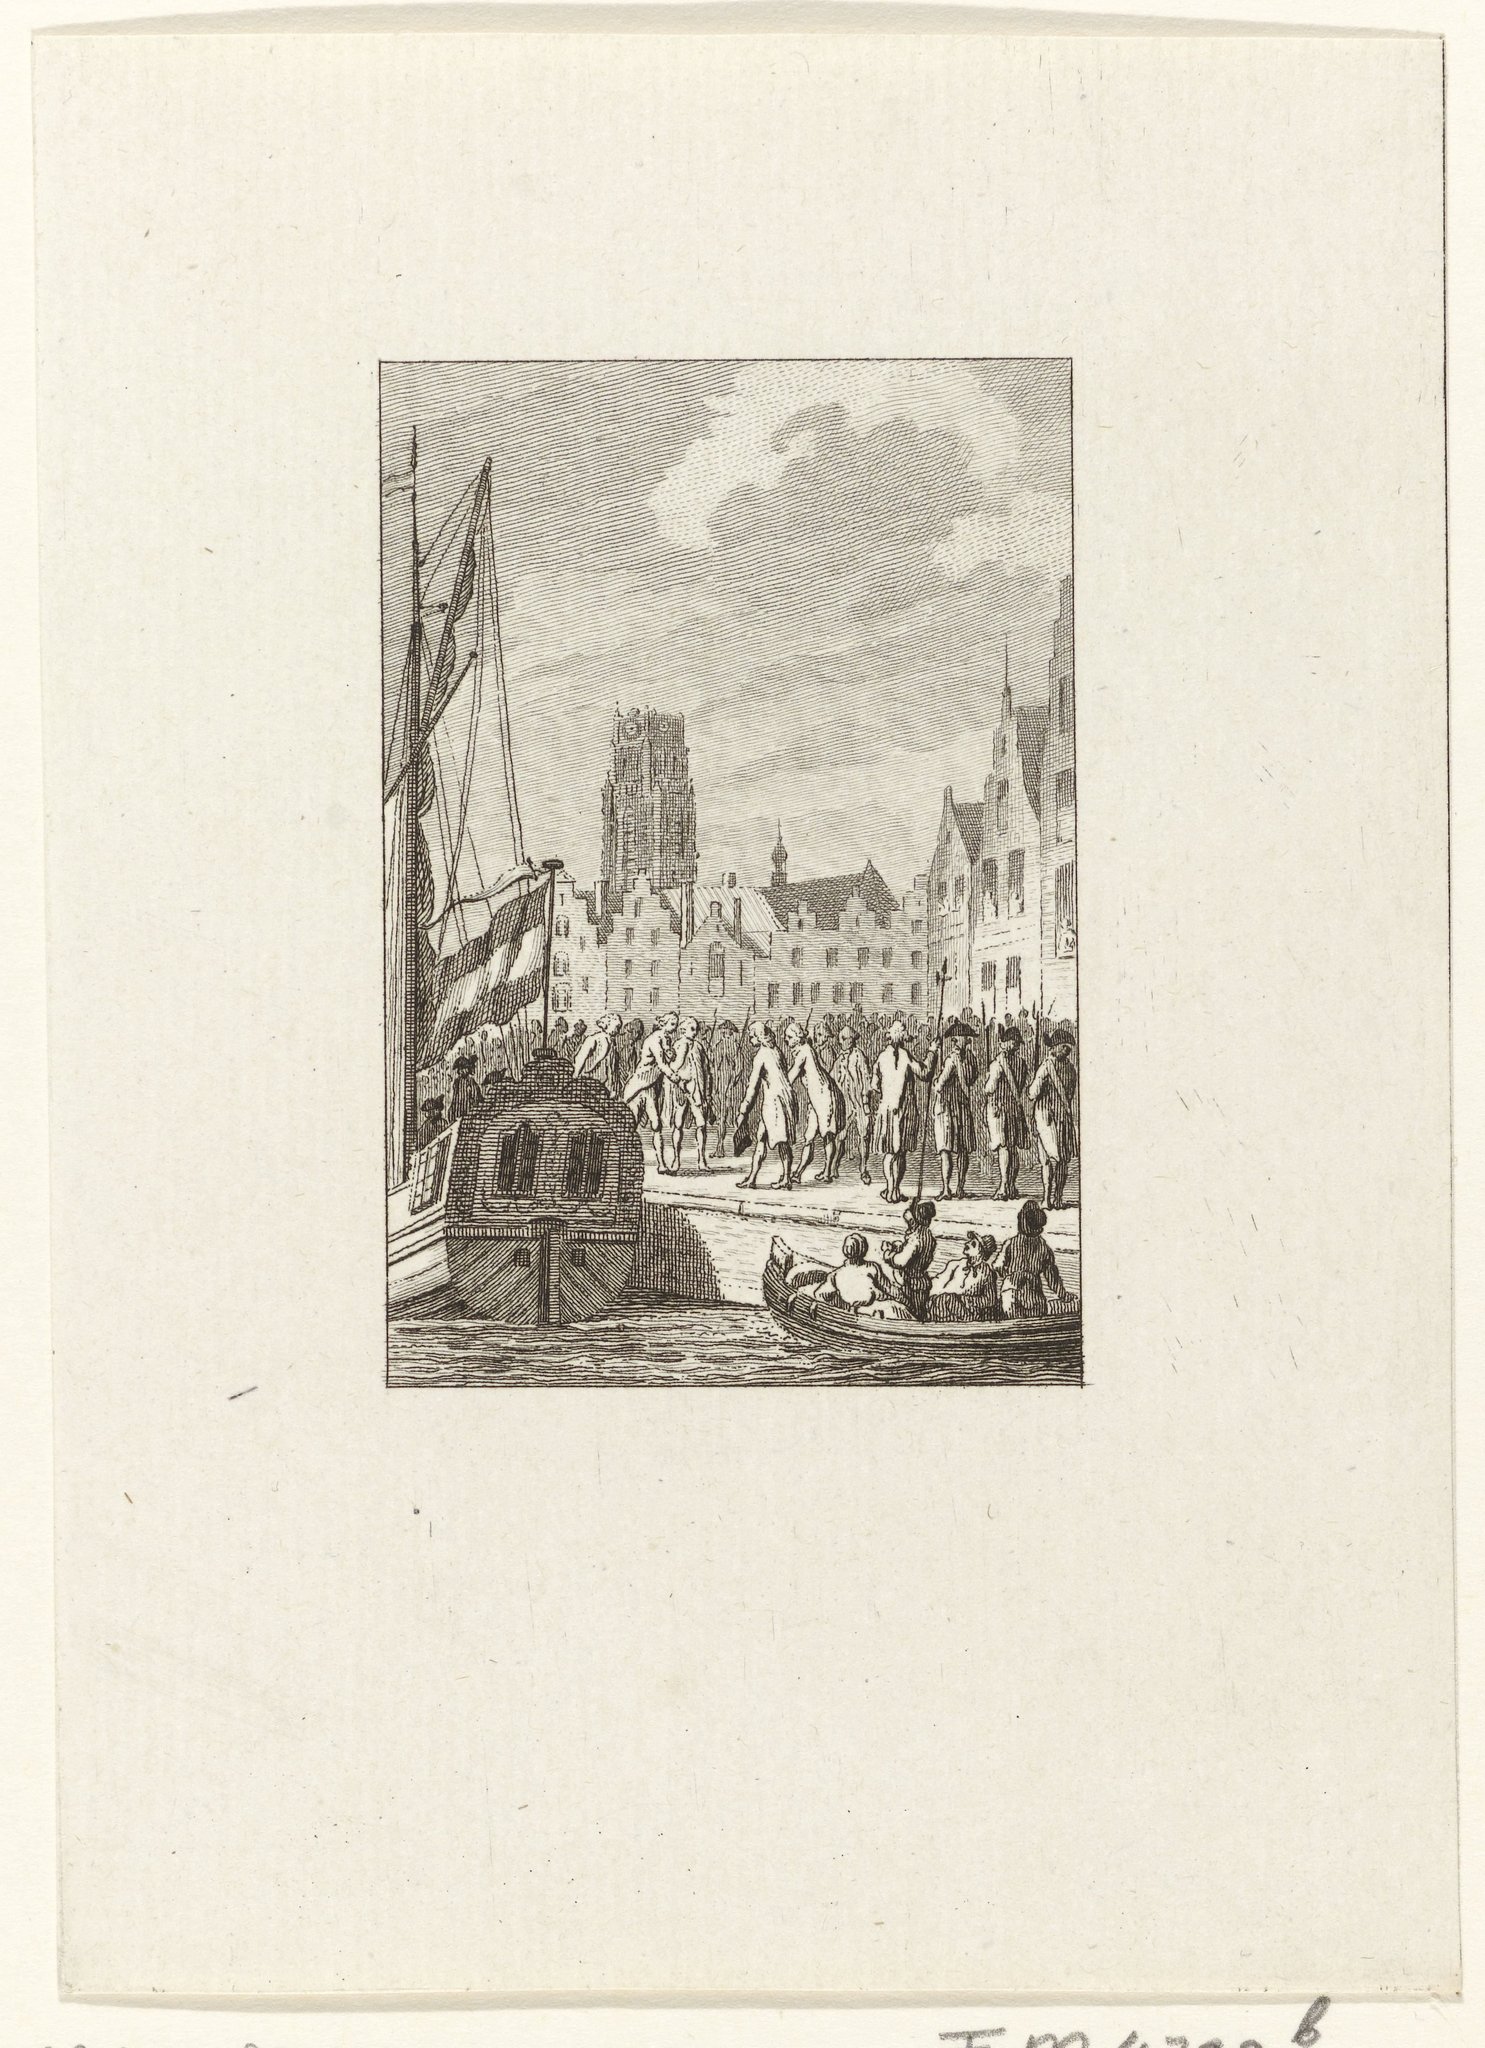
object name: print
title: Vertrek van de Staten Commissie van Rotterdam, 1786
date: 1786-1795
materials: paper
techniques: engraving, etching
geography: northern netherlands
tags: departure ~ travelling, rotterdam, patriots (1780-1795)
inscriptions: collector's mark: Lugt 2228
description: Gebruikt als illustratie in: J. Fokke, Geschiedenissen der Vereenigde Nederlanden voor de vaderlandsche jeugd, Johannes Allart, Amsterdam 1783-1795, 25 delen, dl. 16, pl. 7.